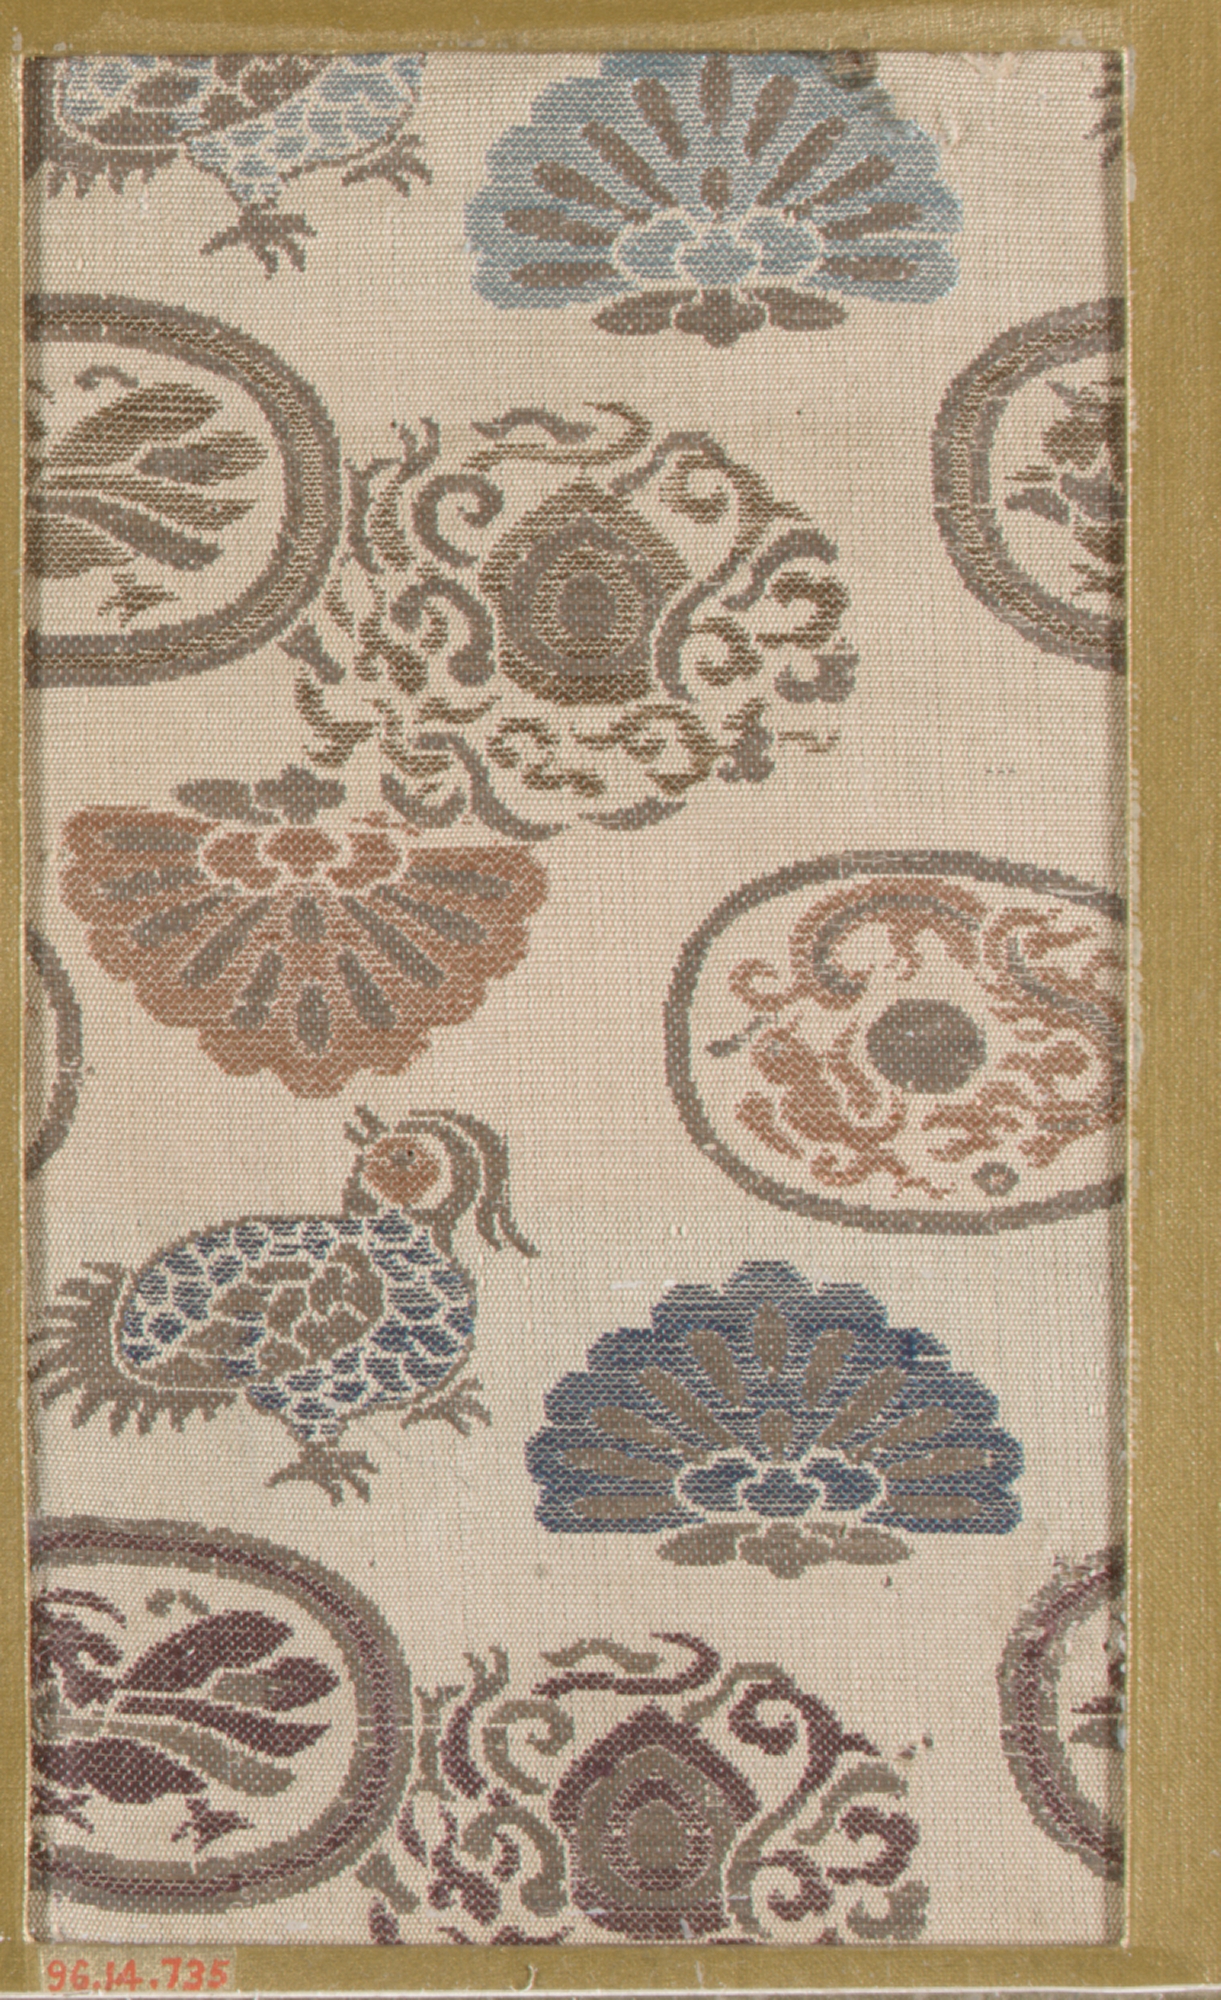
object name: piece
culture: japanese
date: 1701-1900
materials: silk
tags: birds